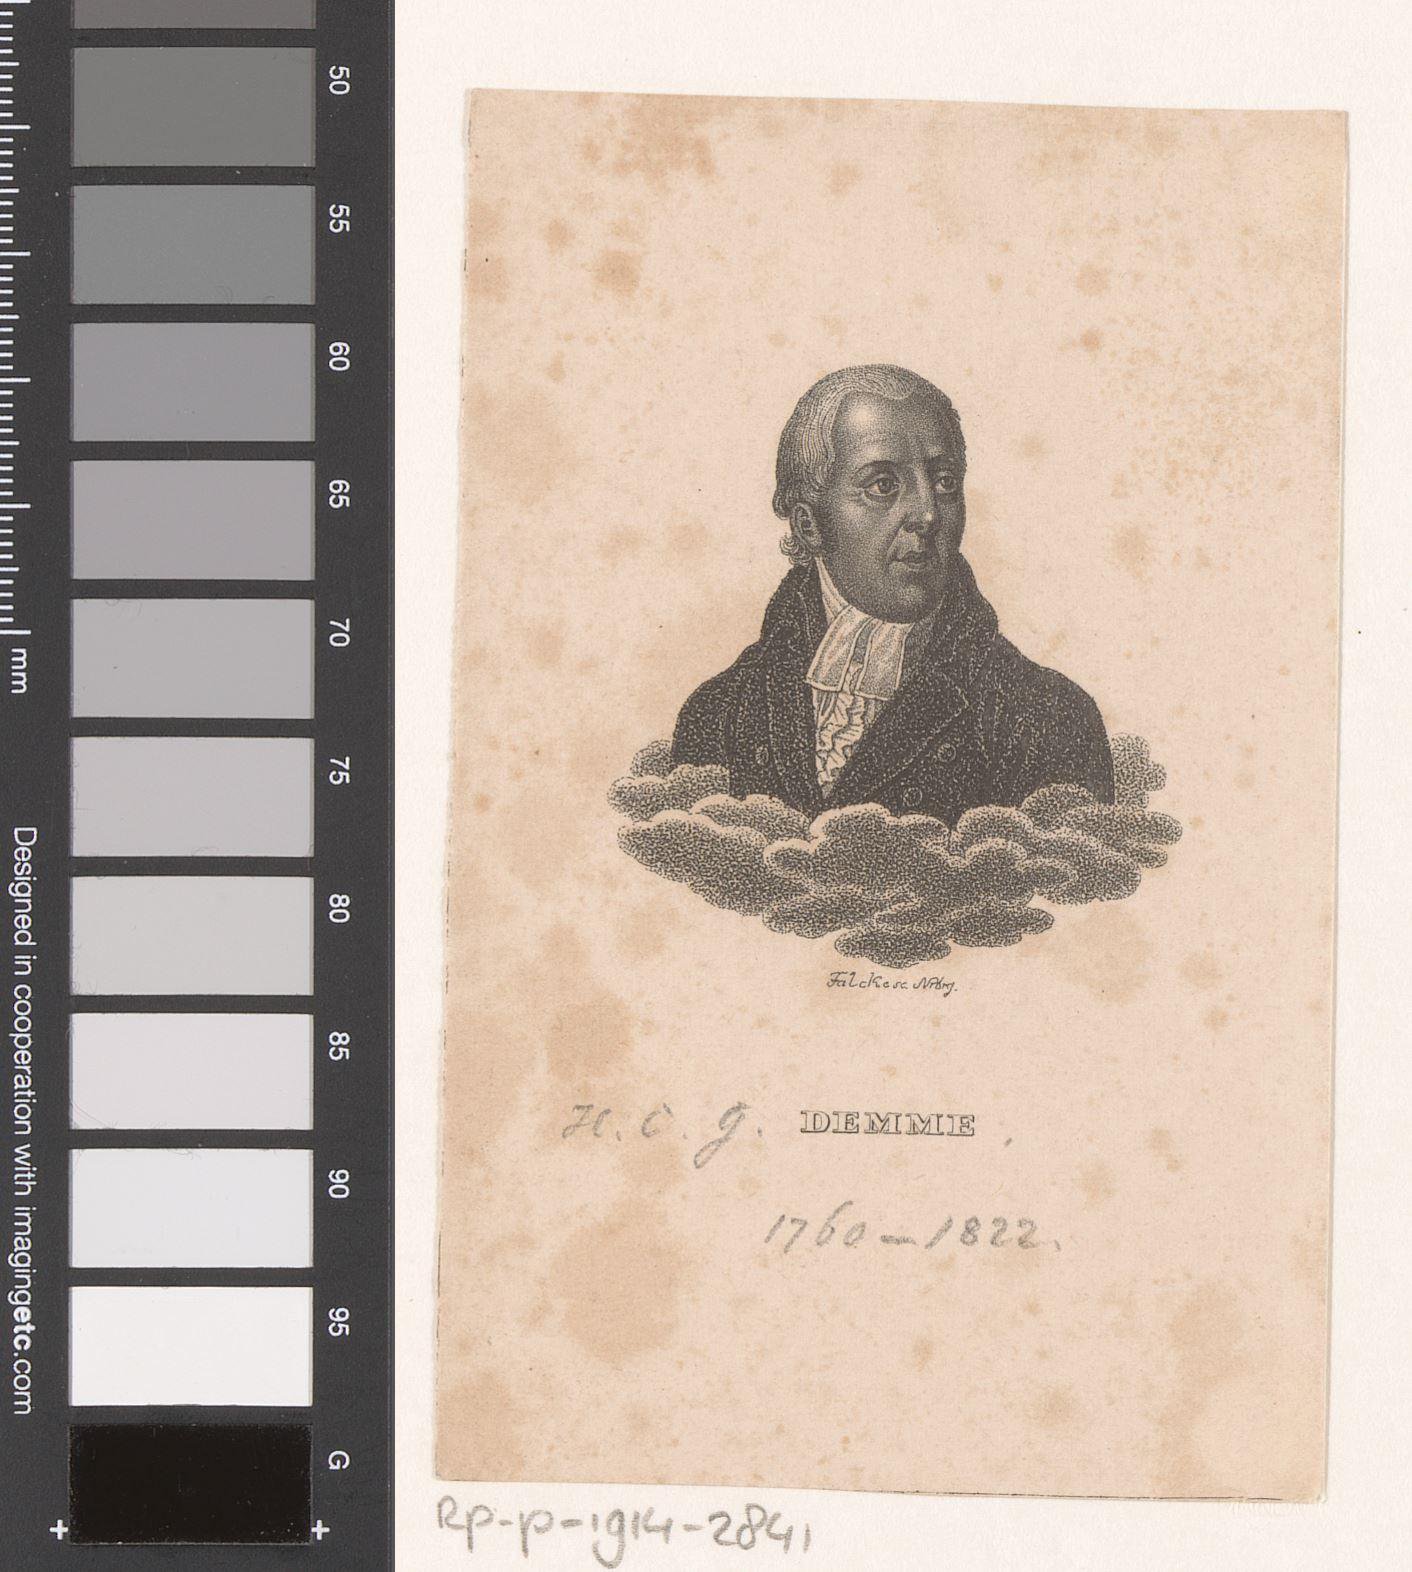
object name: print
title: Portret van Hermann Christian Gottfried Demme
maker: tobias falke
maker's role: print maker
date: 1822-1830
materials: paper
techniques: stippling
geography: nuremberg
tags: mühlhausen, clouds, historical persons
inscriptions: collector's mark: Lugt 2228